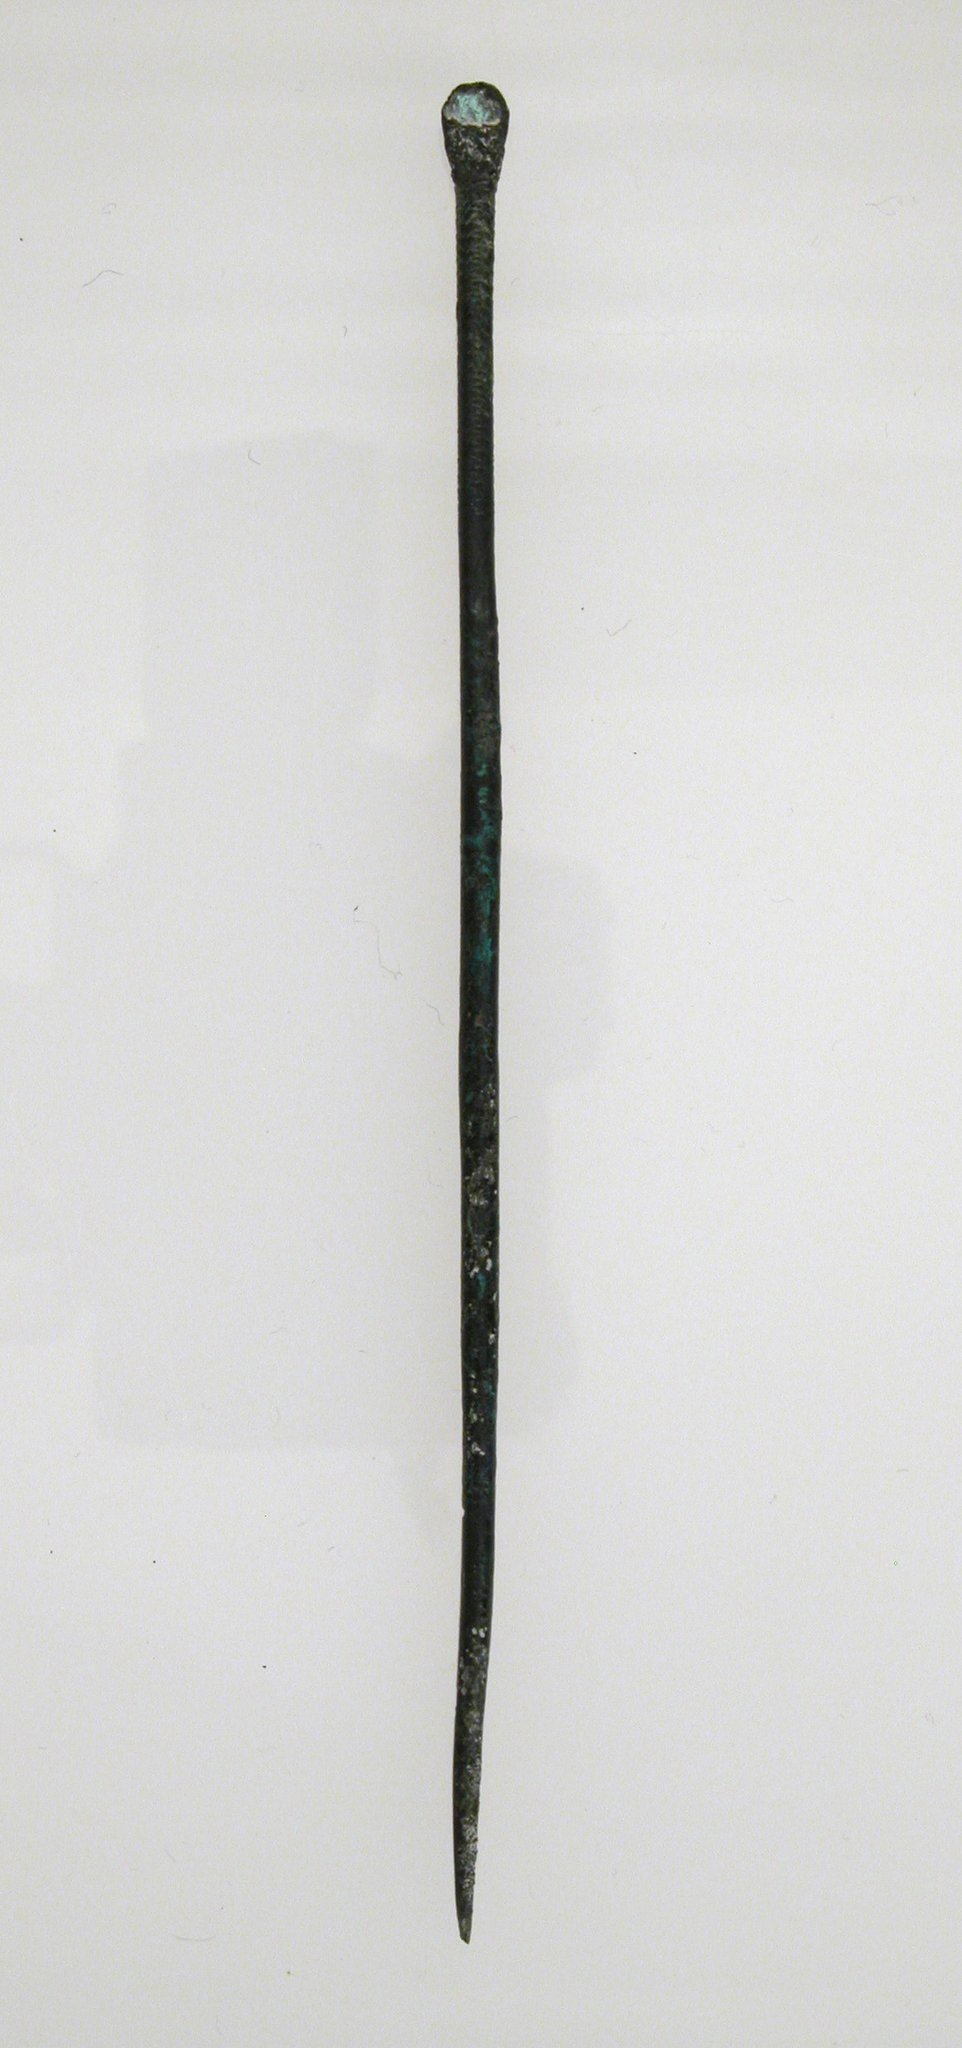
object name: hairpin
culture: frankish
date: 601-700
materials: bronze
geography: germany